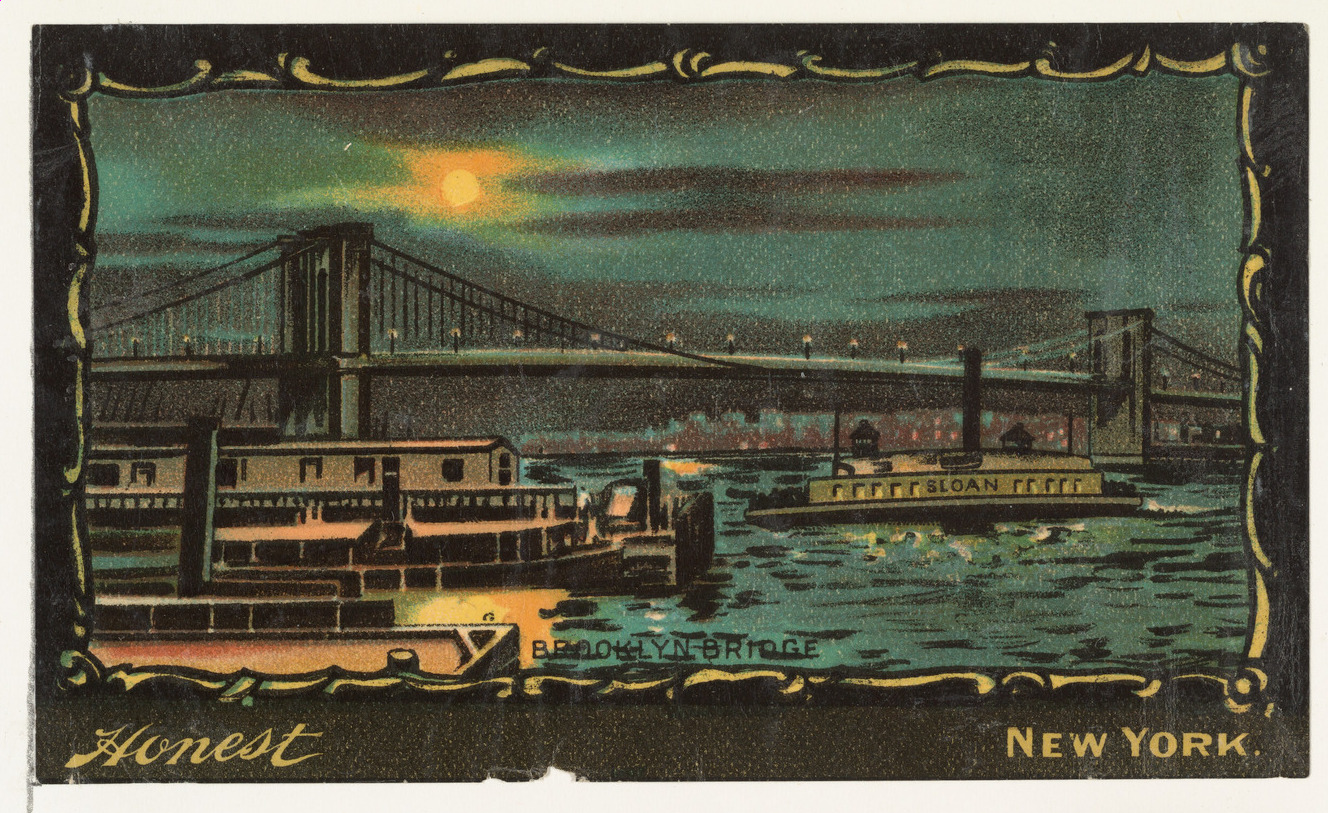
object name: print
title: Brooklyn Bridge, from the Transparencies series (N137) issued by W. Duke, Sons & Co. to promote Honest Long Cut Tobacco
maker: w. duke, sons & co.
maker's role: publisher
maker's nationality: american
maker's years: 1870-1920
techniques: color lithograph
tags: bridges,boats,new york city